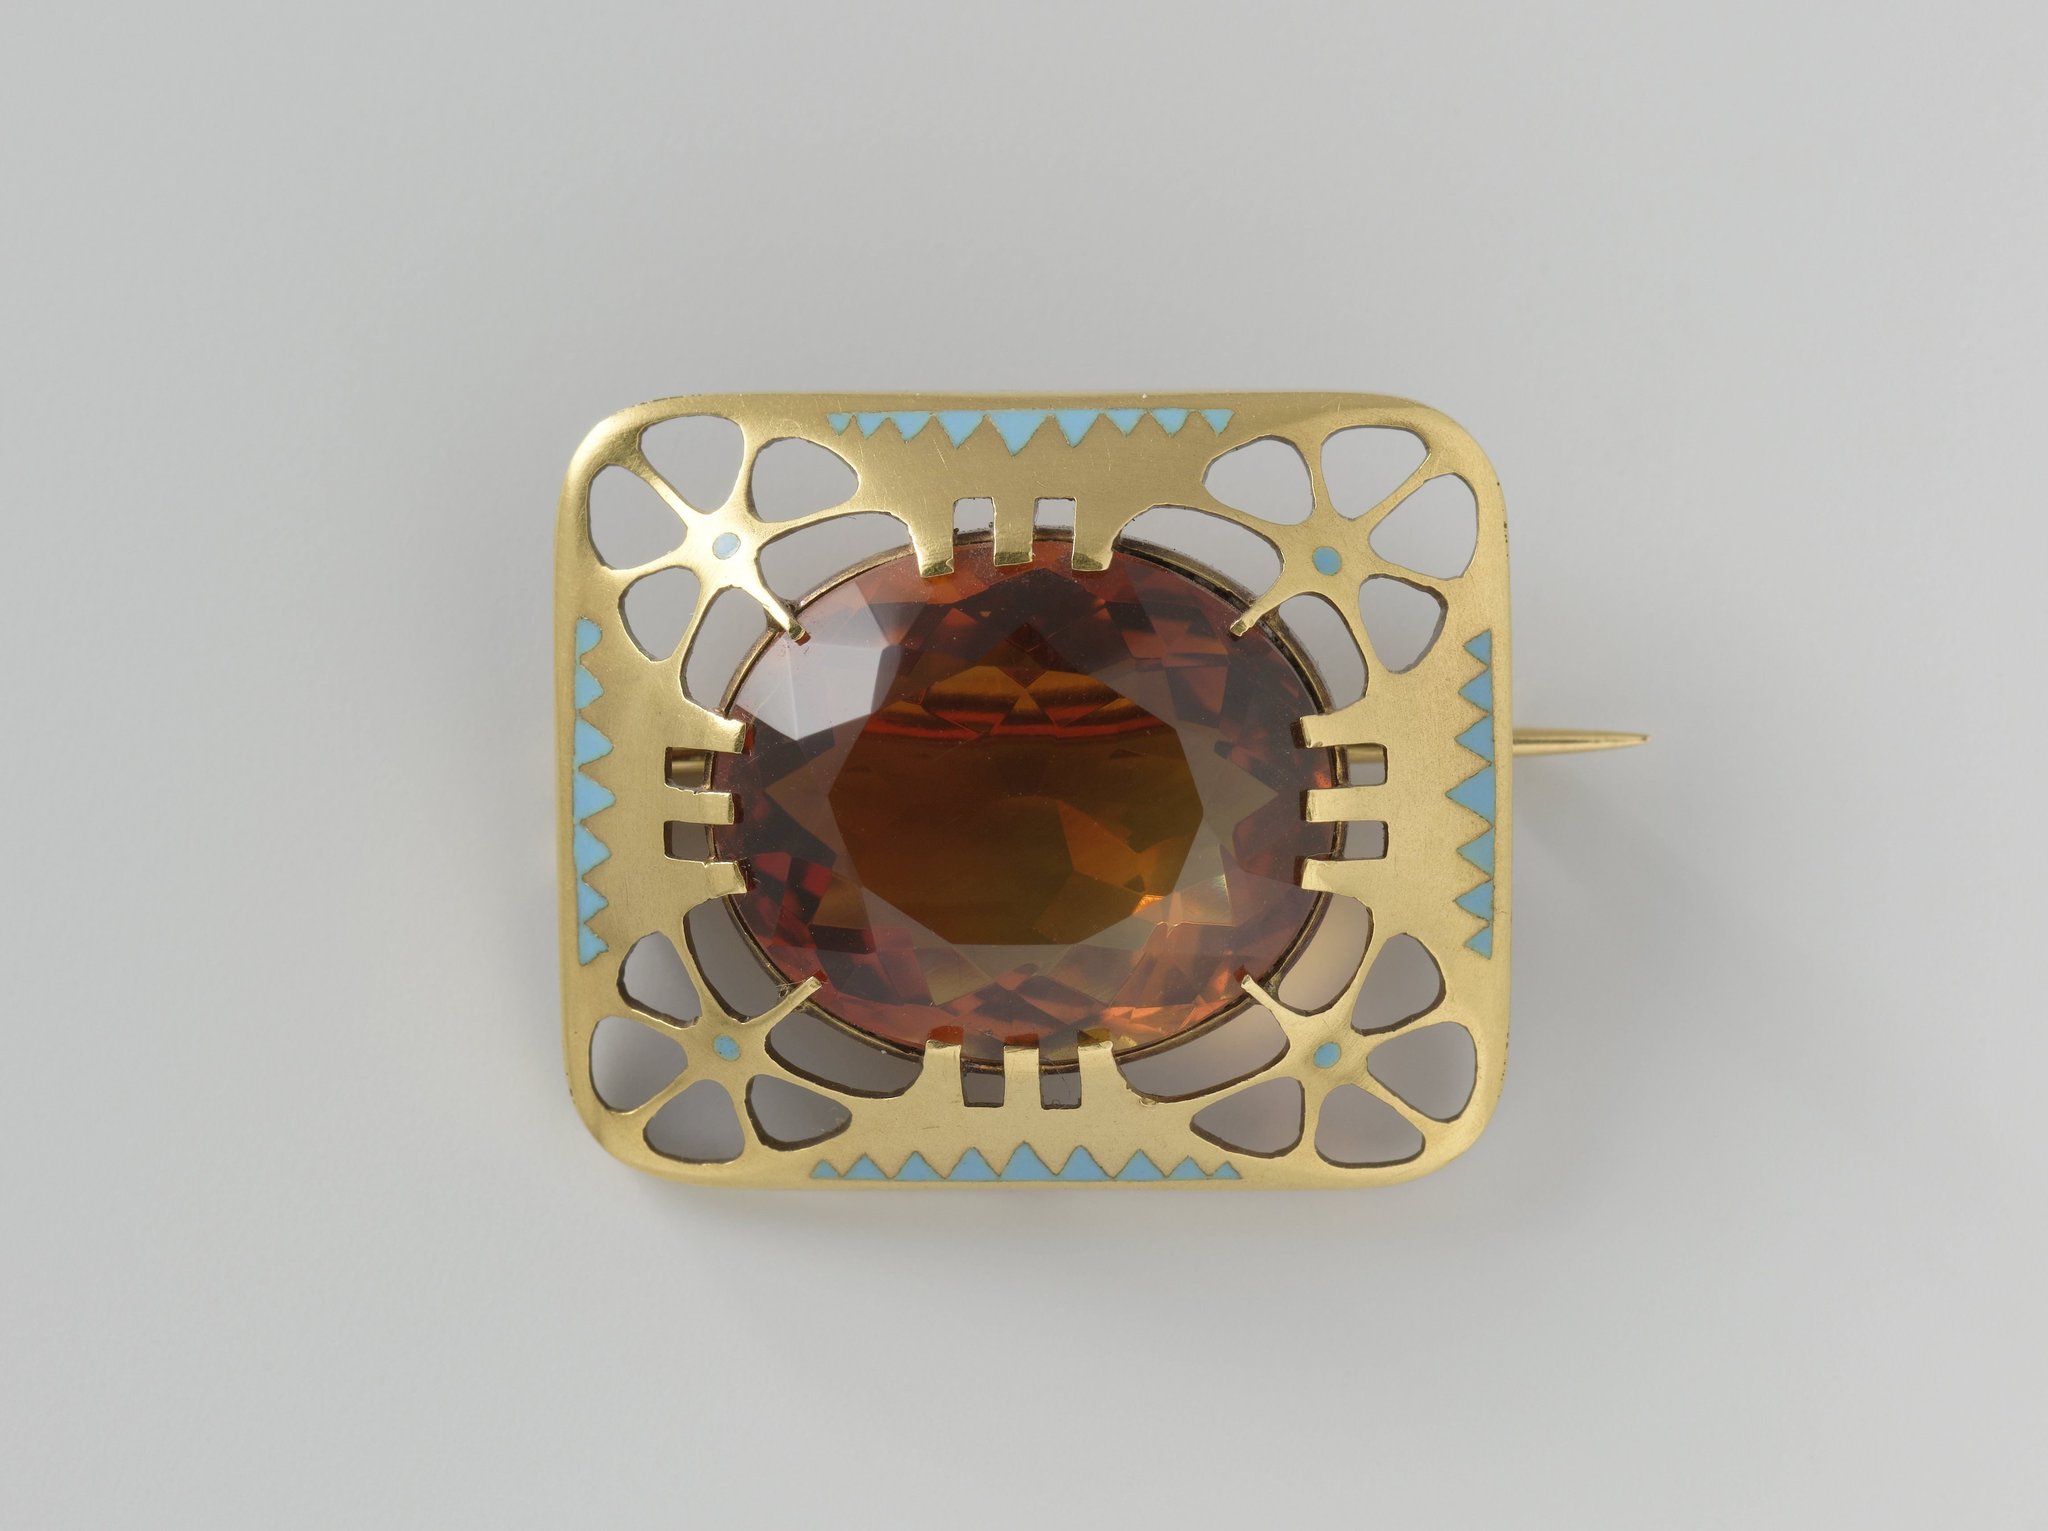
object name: brooch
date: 1908-1911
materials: gold, gemstone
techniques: enameling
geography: amsterdam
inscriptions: alloy mark, maker's mark, alloy mark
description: Nieuwe Kunst designers had a wide range of interests. Known primarily as a potter, Bert Nienhuis also designed this brooch – as well as the other brooches and necklaces on view here. The jewels are related to his pottery designs. Their forms are clearer, the simplicity underscored by the abstract enamel ornamentation.